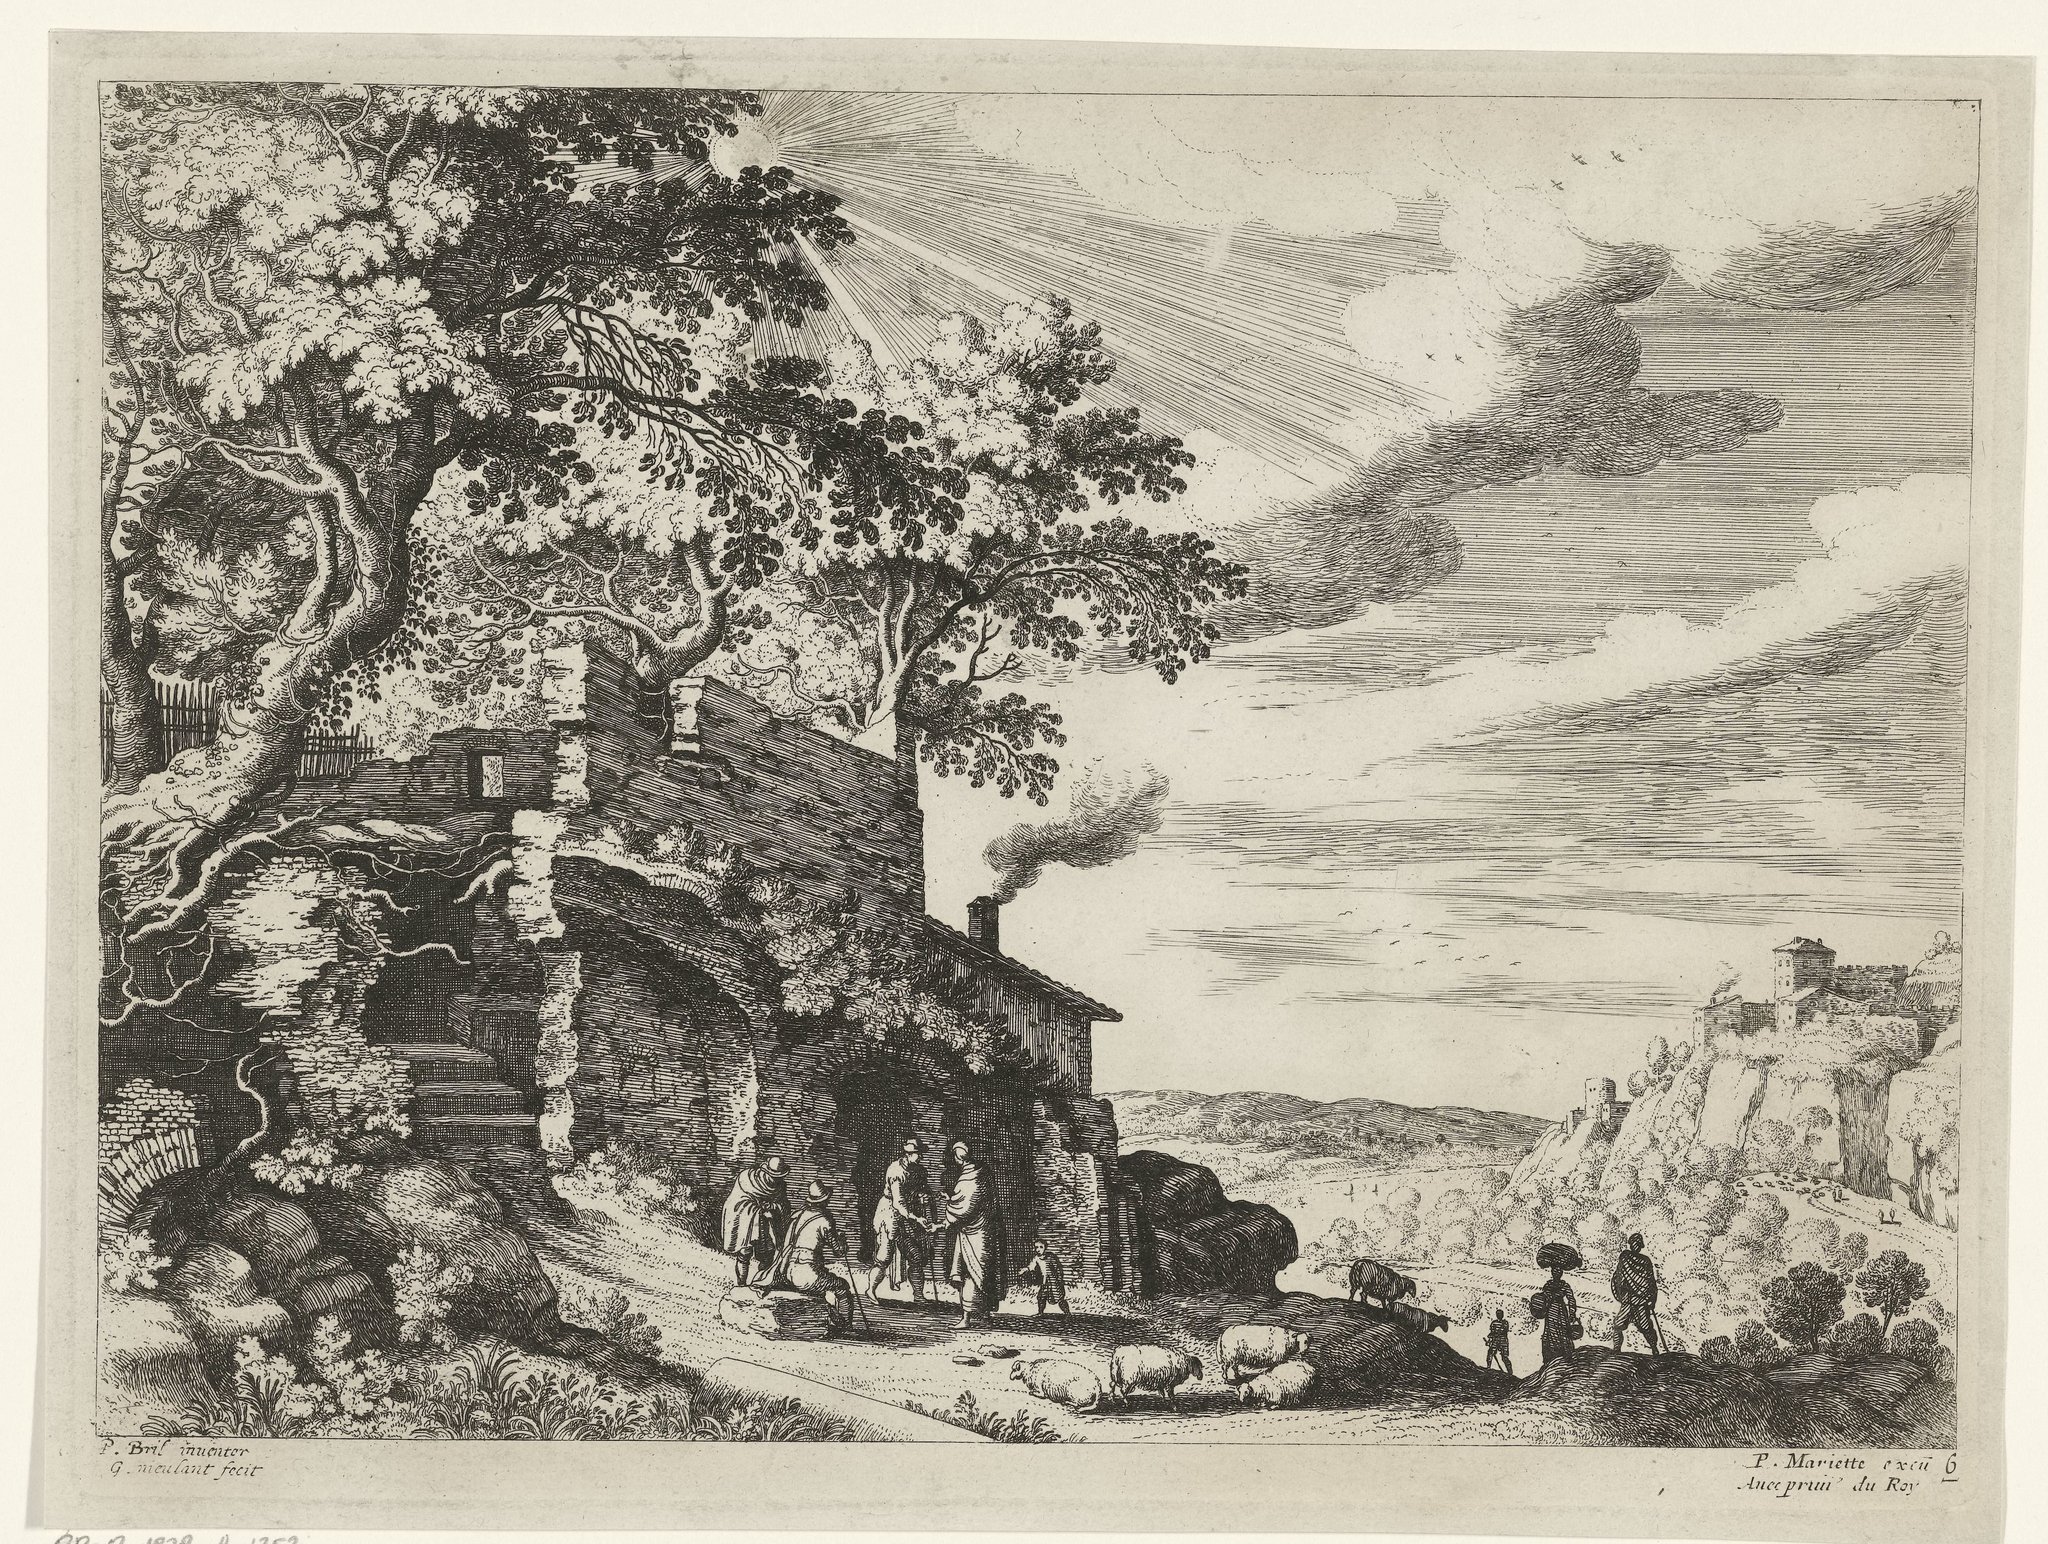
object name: print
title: Herders bij een ruïne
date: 1594-1635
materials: paper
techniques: engraving, etching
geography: paris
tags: herding, herdsman, herdswoman, shepherd, shepherdess, cowherd, etc., landscape with ruins, pastorals, arcadian scenes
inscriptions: collector's mark: Lugt 2228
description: Voor een ruïne, die deels is overwoekerd door bomen, staan enkele herders met hun schapen. Rechts uitzicht op een vallei. Prent uit een serie Italiaanse landschappen.